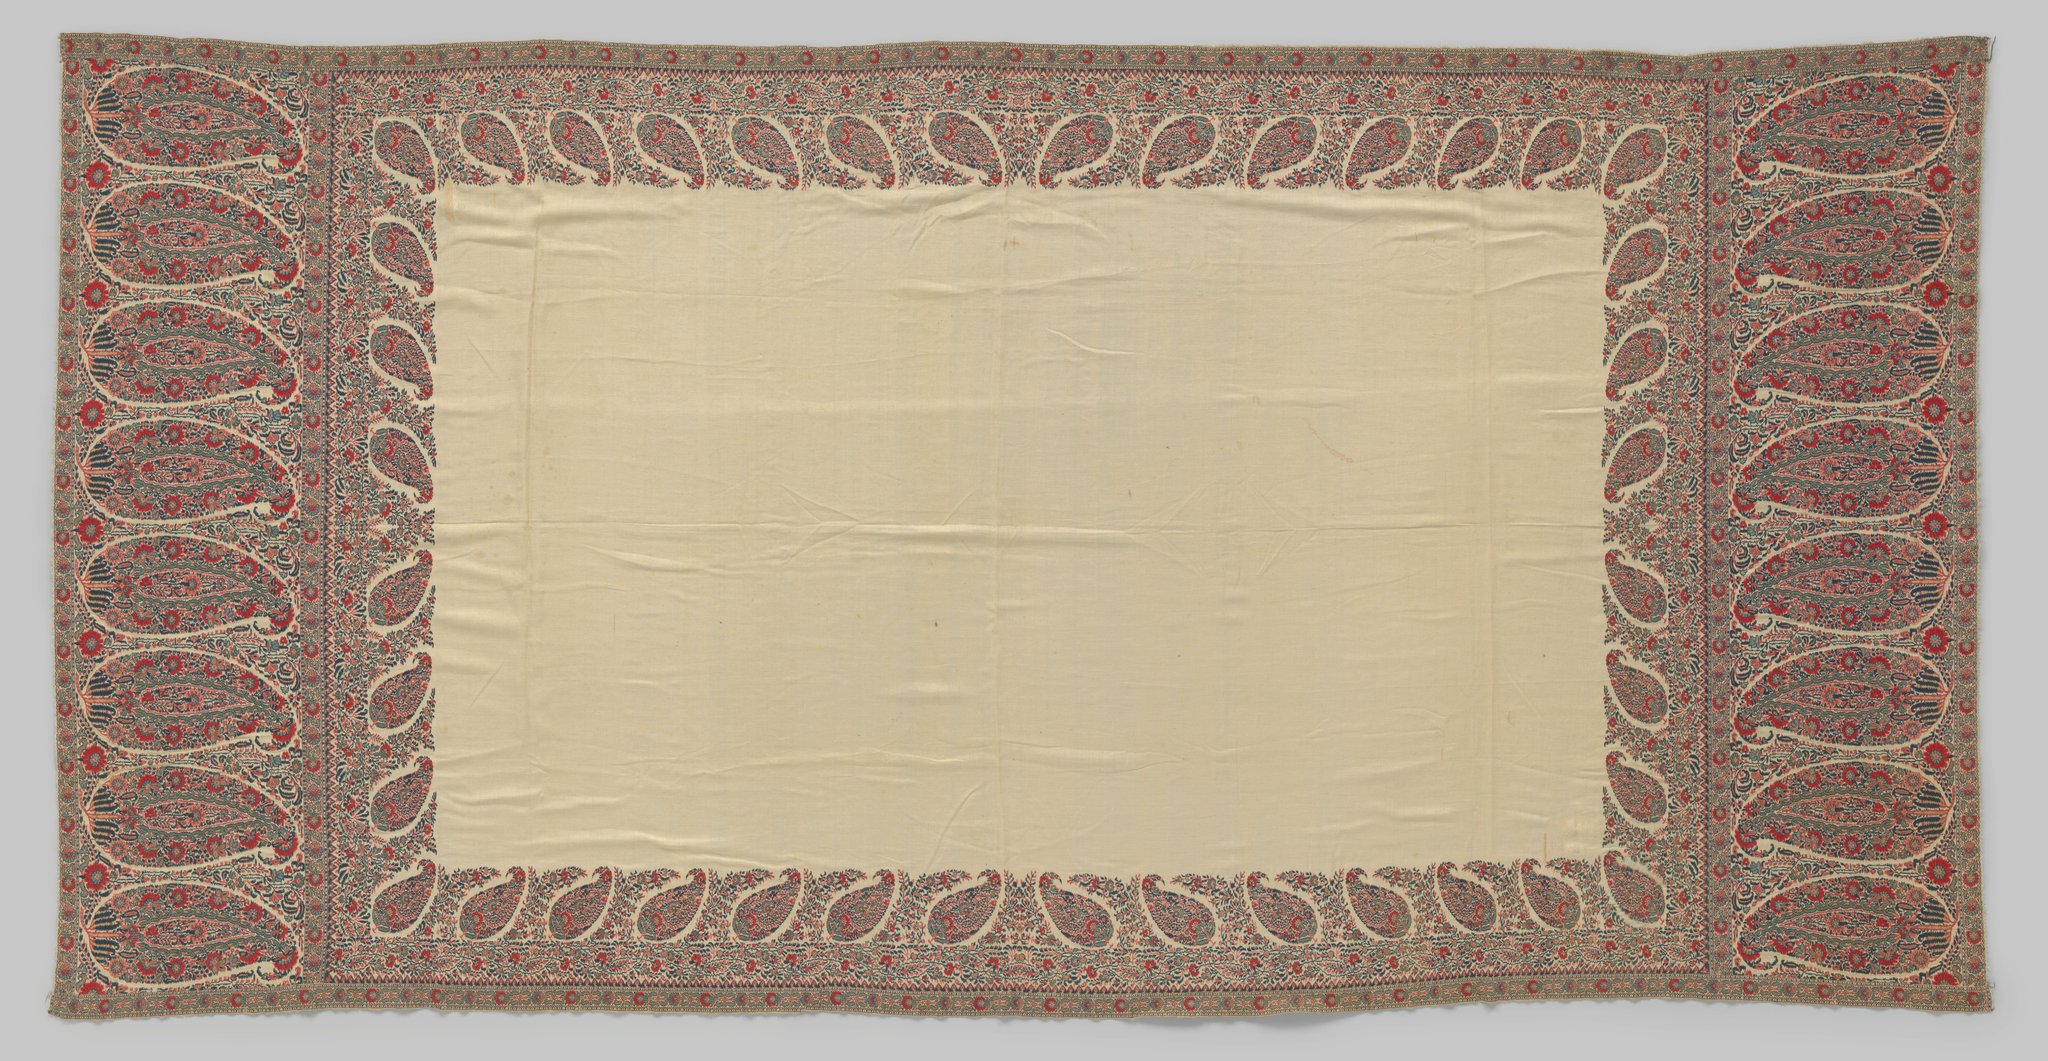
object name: clothing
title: Sjaal van zijde en wol met een naturelkleurige spiegel en rondom randen van buta's in rood, blauw, geel en groen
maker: Anonymous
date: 1800-1825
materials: silk, wool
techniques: weave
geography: east indies